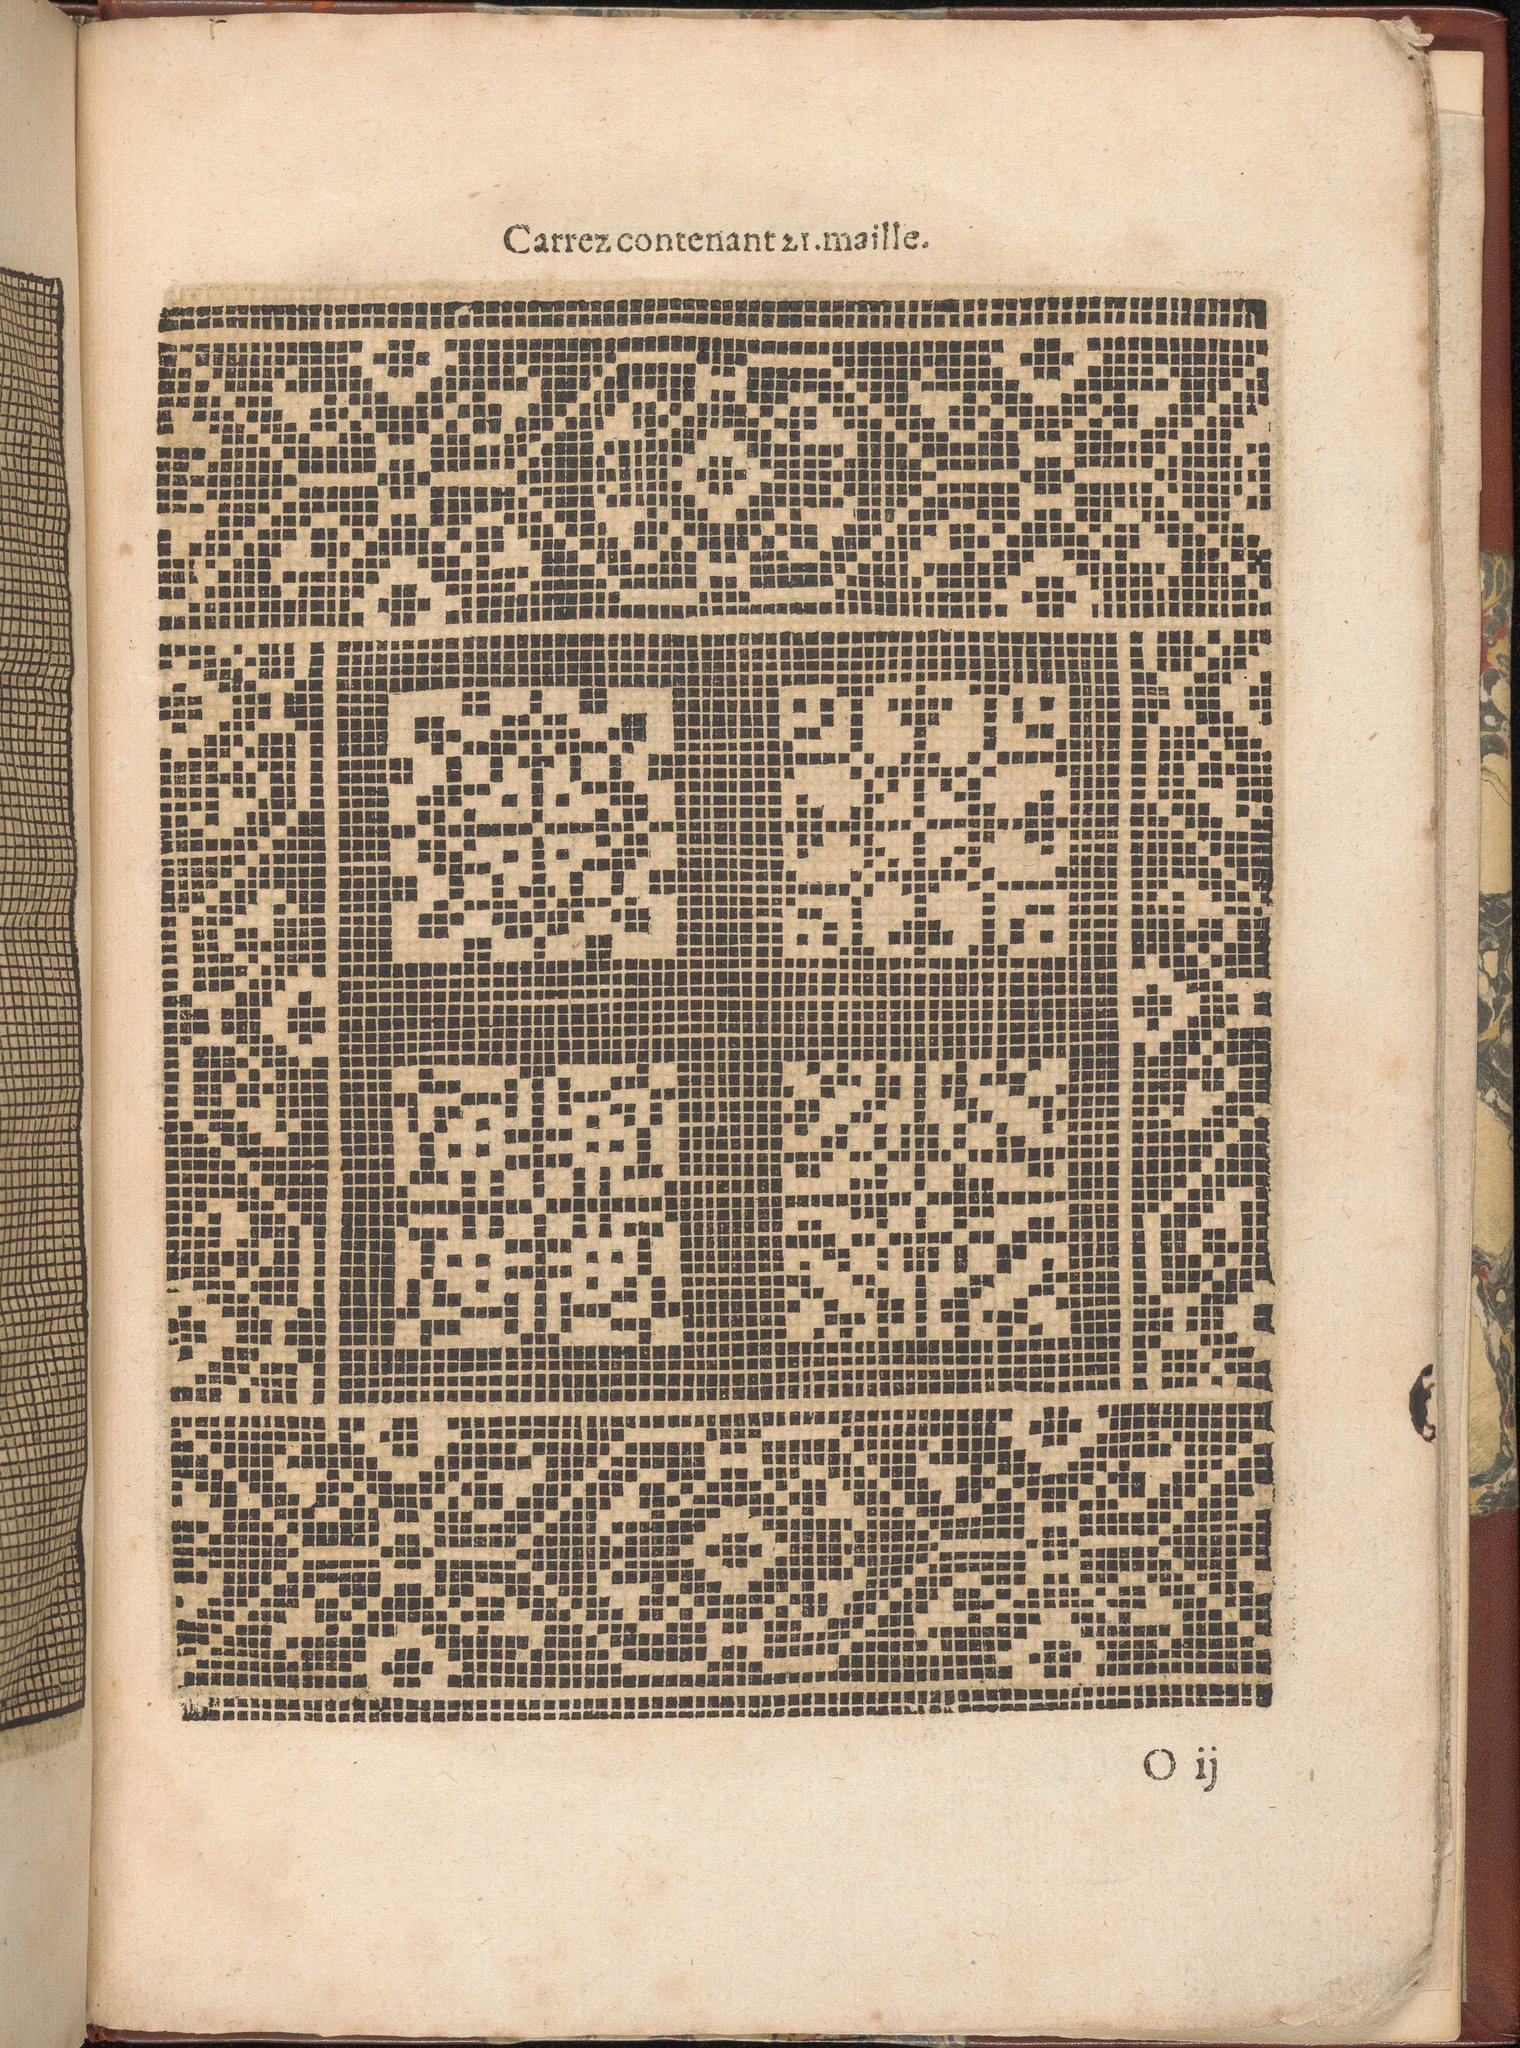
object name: book print ornament architecture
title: Les Secondes Oeuvres, et Subtiles Inventions De Lingerie du Seigneur Federic de Vinciolo Venitien, page 54 (recto)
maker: federico de vinciolo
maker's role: designer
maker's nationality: italian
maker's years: 1582-1599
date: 1603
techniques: woodcut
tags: ornament